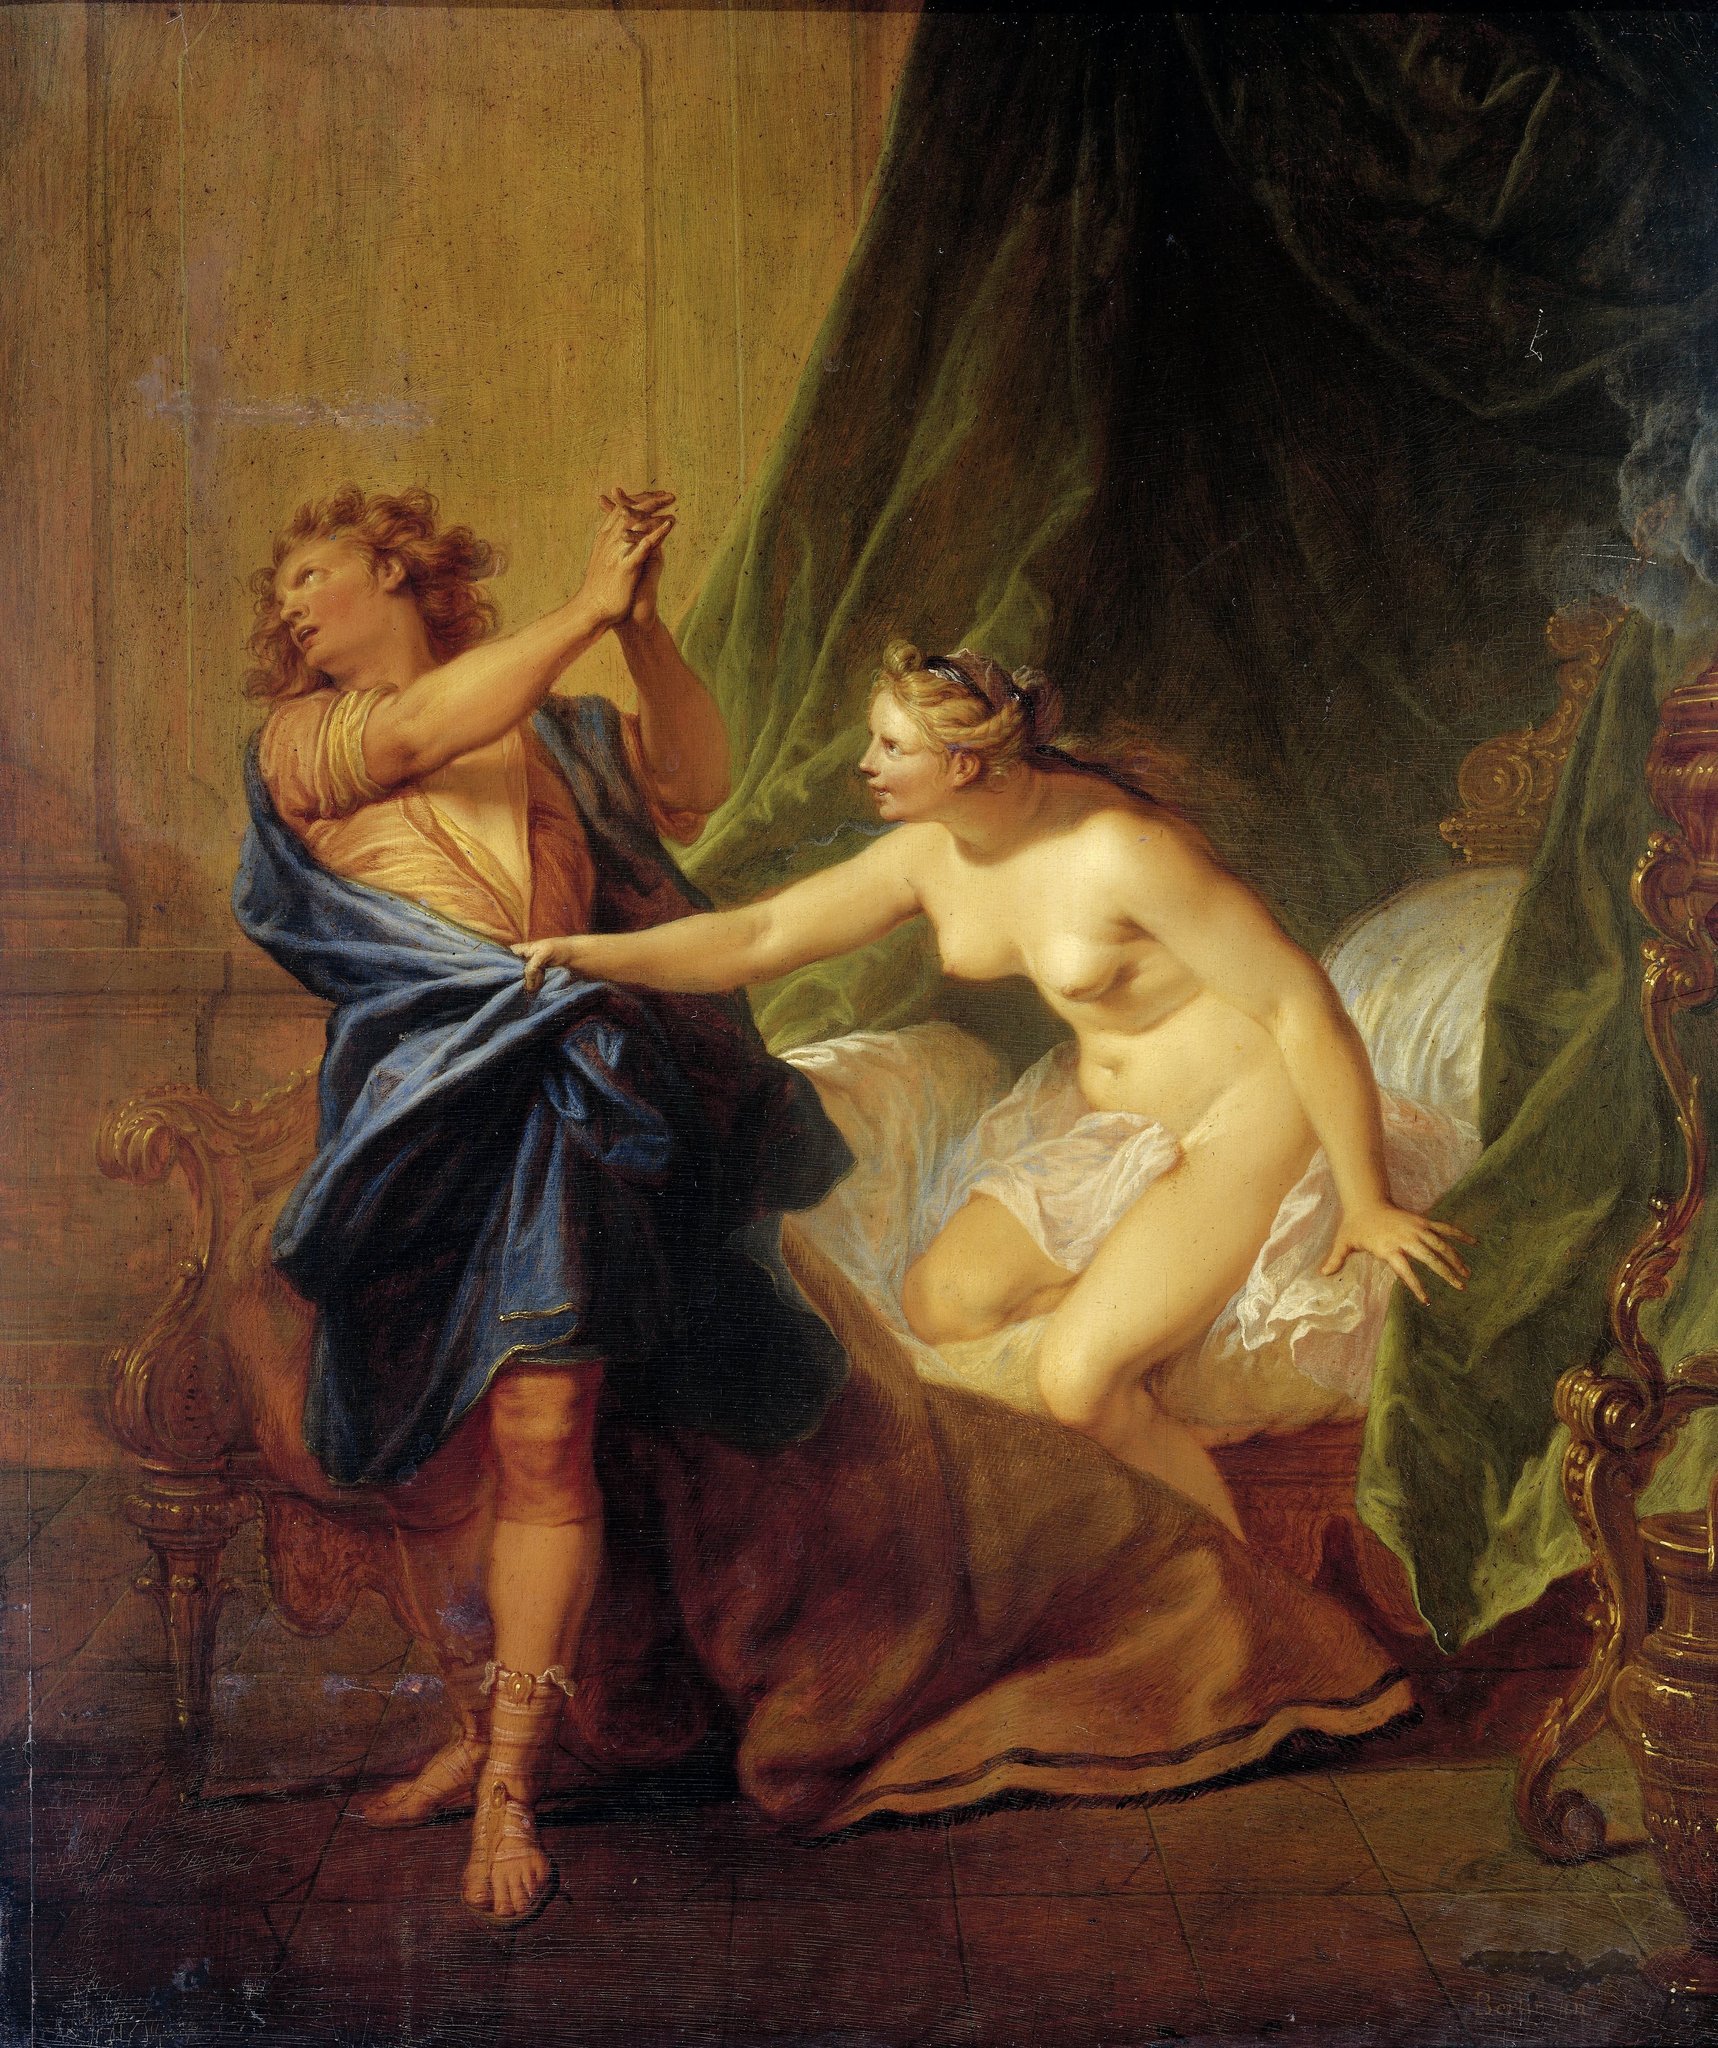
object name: painting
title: Joseph and Potiphar's Wife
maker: nicolas bertin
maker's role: painter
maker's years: 1668-1736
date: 1690-1710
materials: oil, panel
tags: potiphar's wife catches joseph by his robe, usually while lying in bed; joseph escapes leaving his cloak behind in her hands (possibly with a naked child lying in a crib)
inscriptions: signature: ‘Bertin in.’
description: Interieur van een slaapkamer waarin de naakte vrouw van Potifar vanuit haar bed Jozef aan zijn mantel trekt. Pendant van SK-A-41.